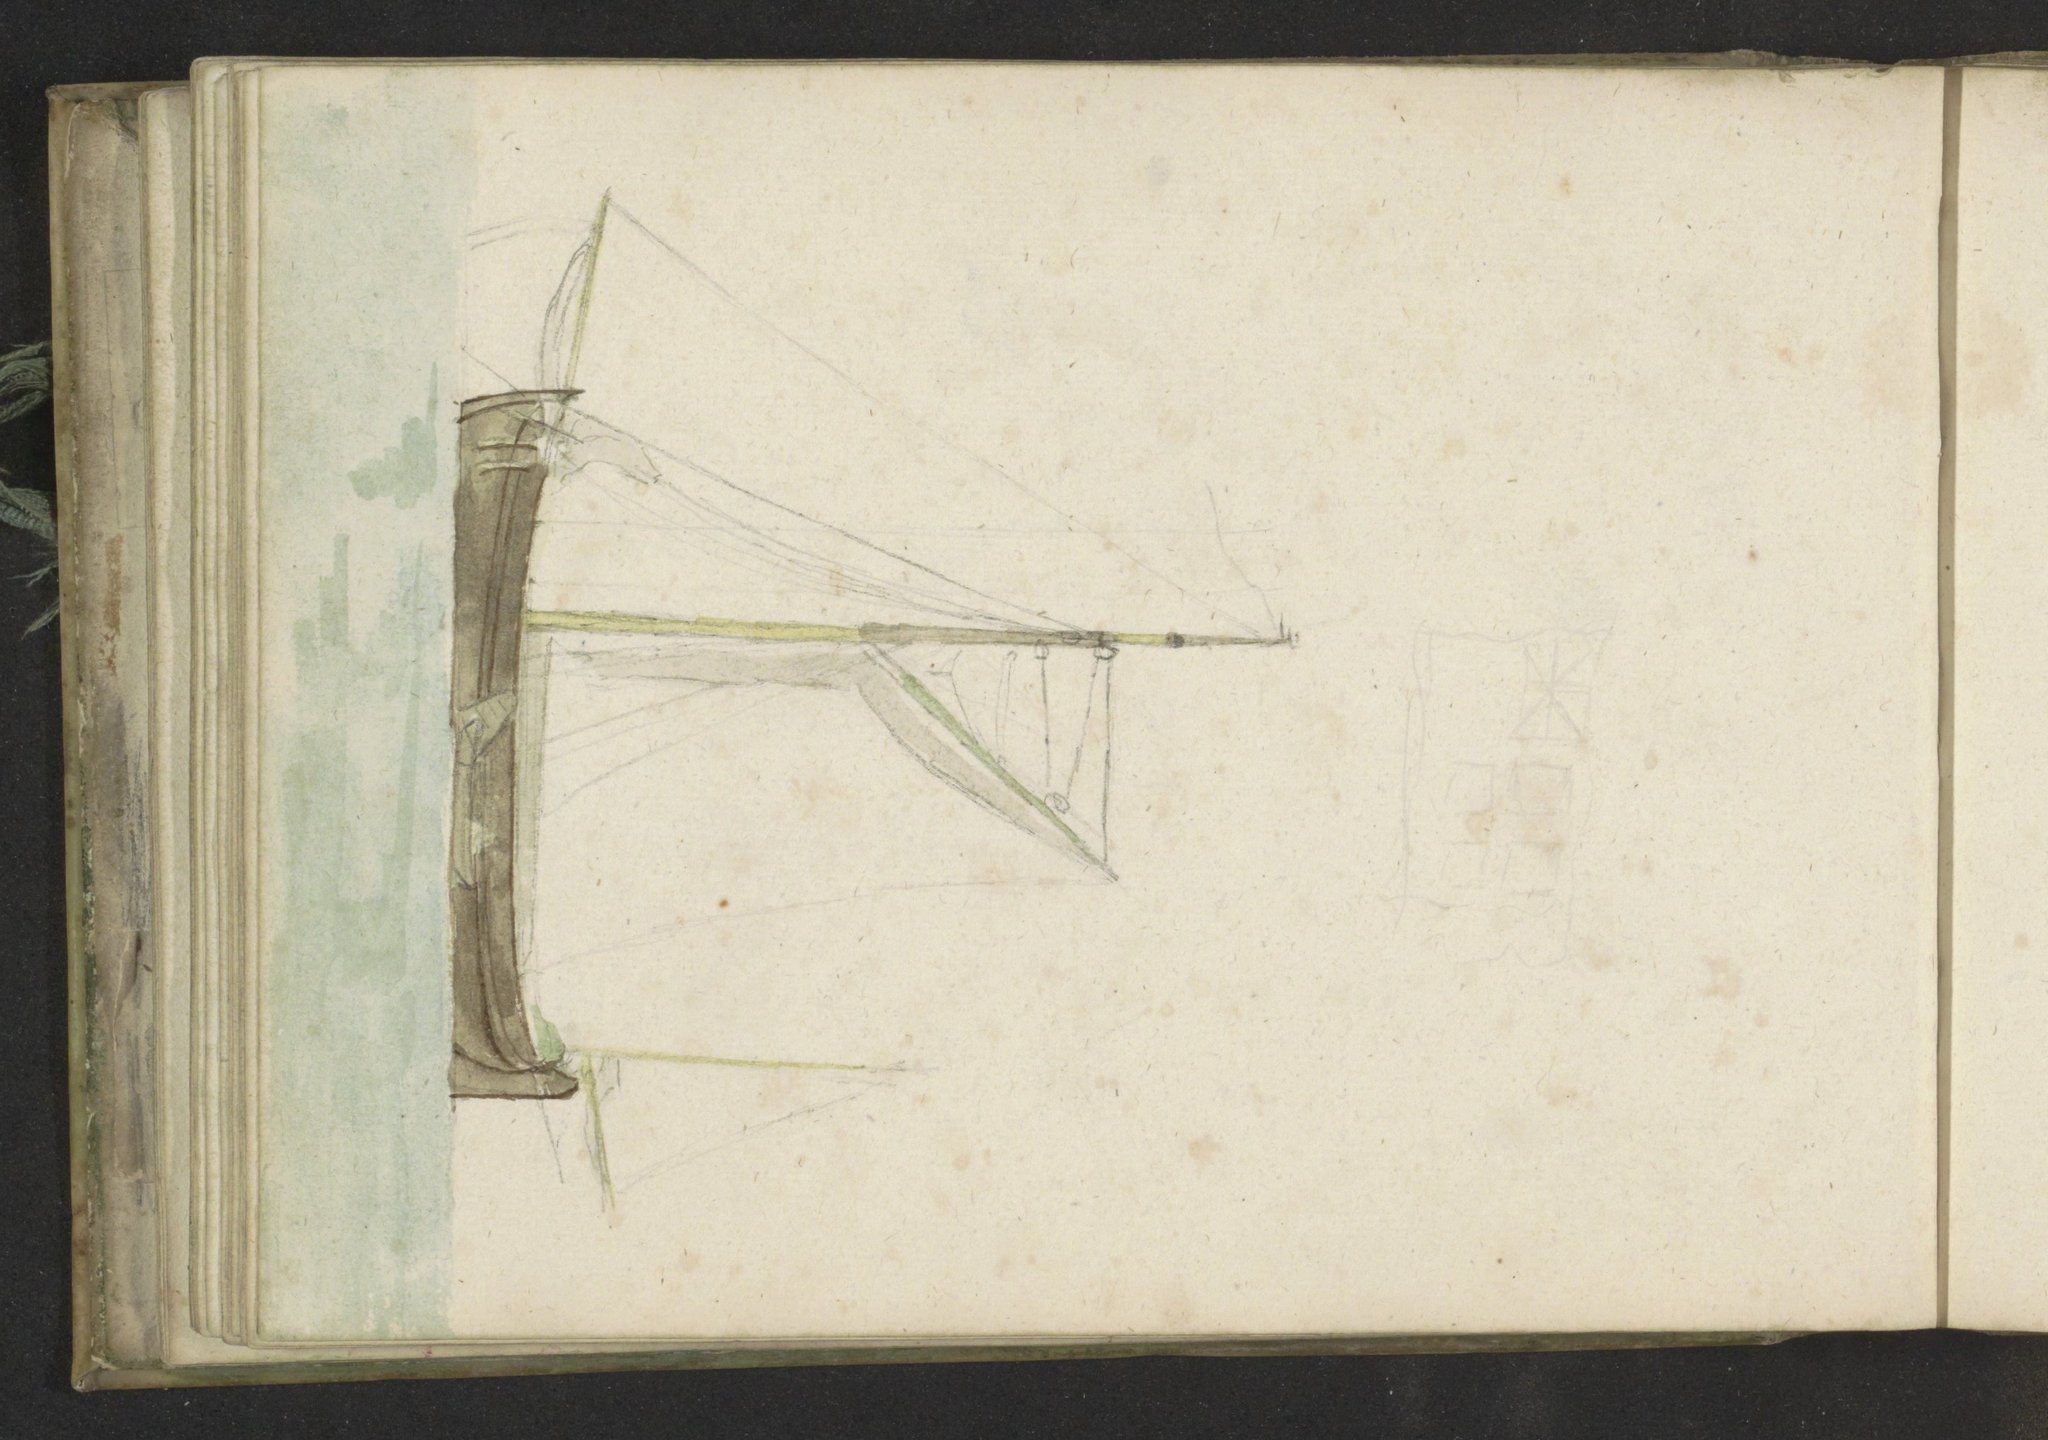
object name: sketchbook leaf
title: Zeilschip op kalm water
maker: martinus schouman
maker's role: draughtsman, painter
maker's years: 1770-1848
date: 1780-1848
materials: ink, paper, pencil, watercolor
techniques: brush, pen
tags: sailing-ship, sailing-boat, landscapes with waters, waterscapes, seascapes (in the temperate zone)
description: Blad 28 verso uit een schetsboek met 53 bladen.